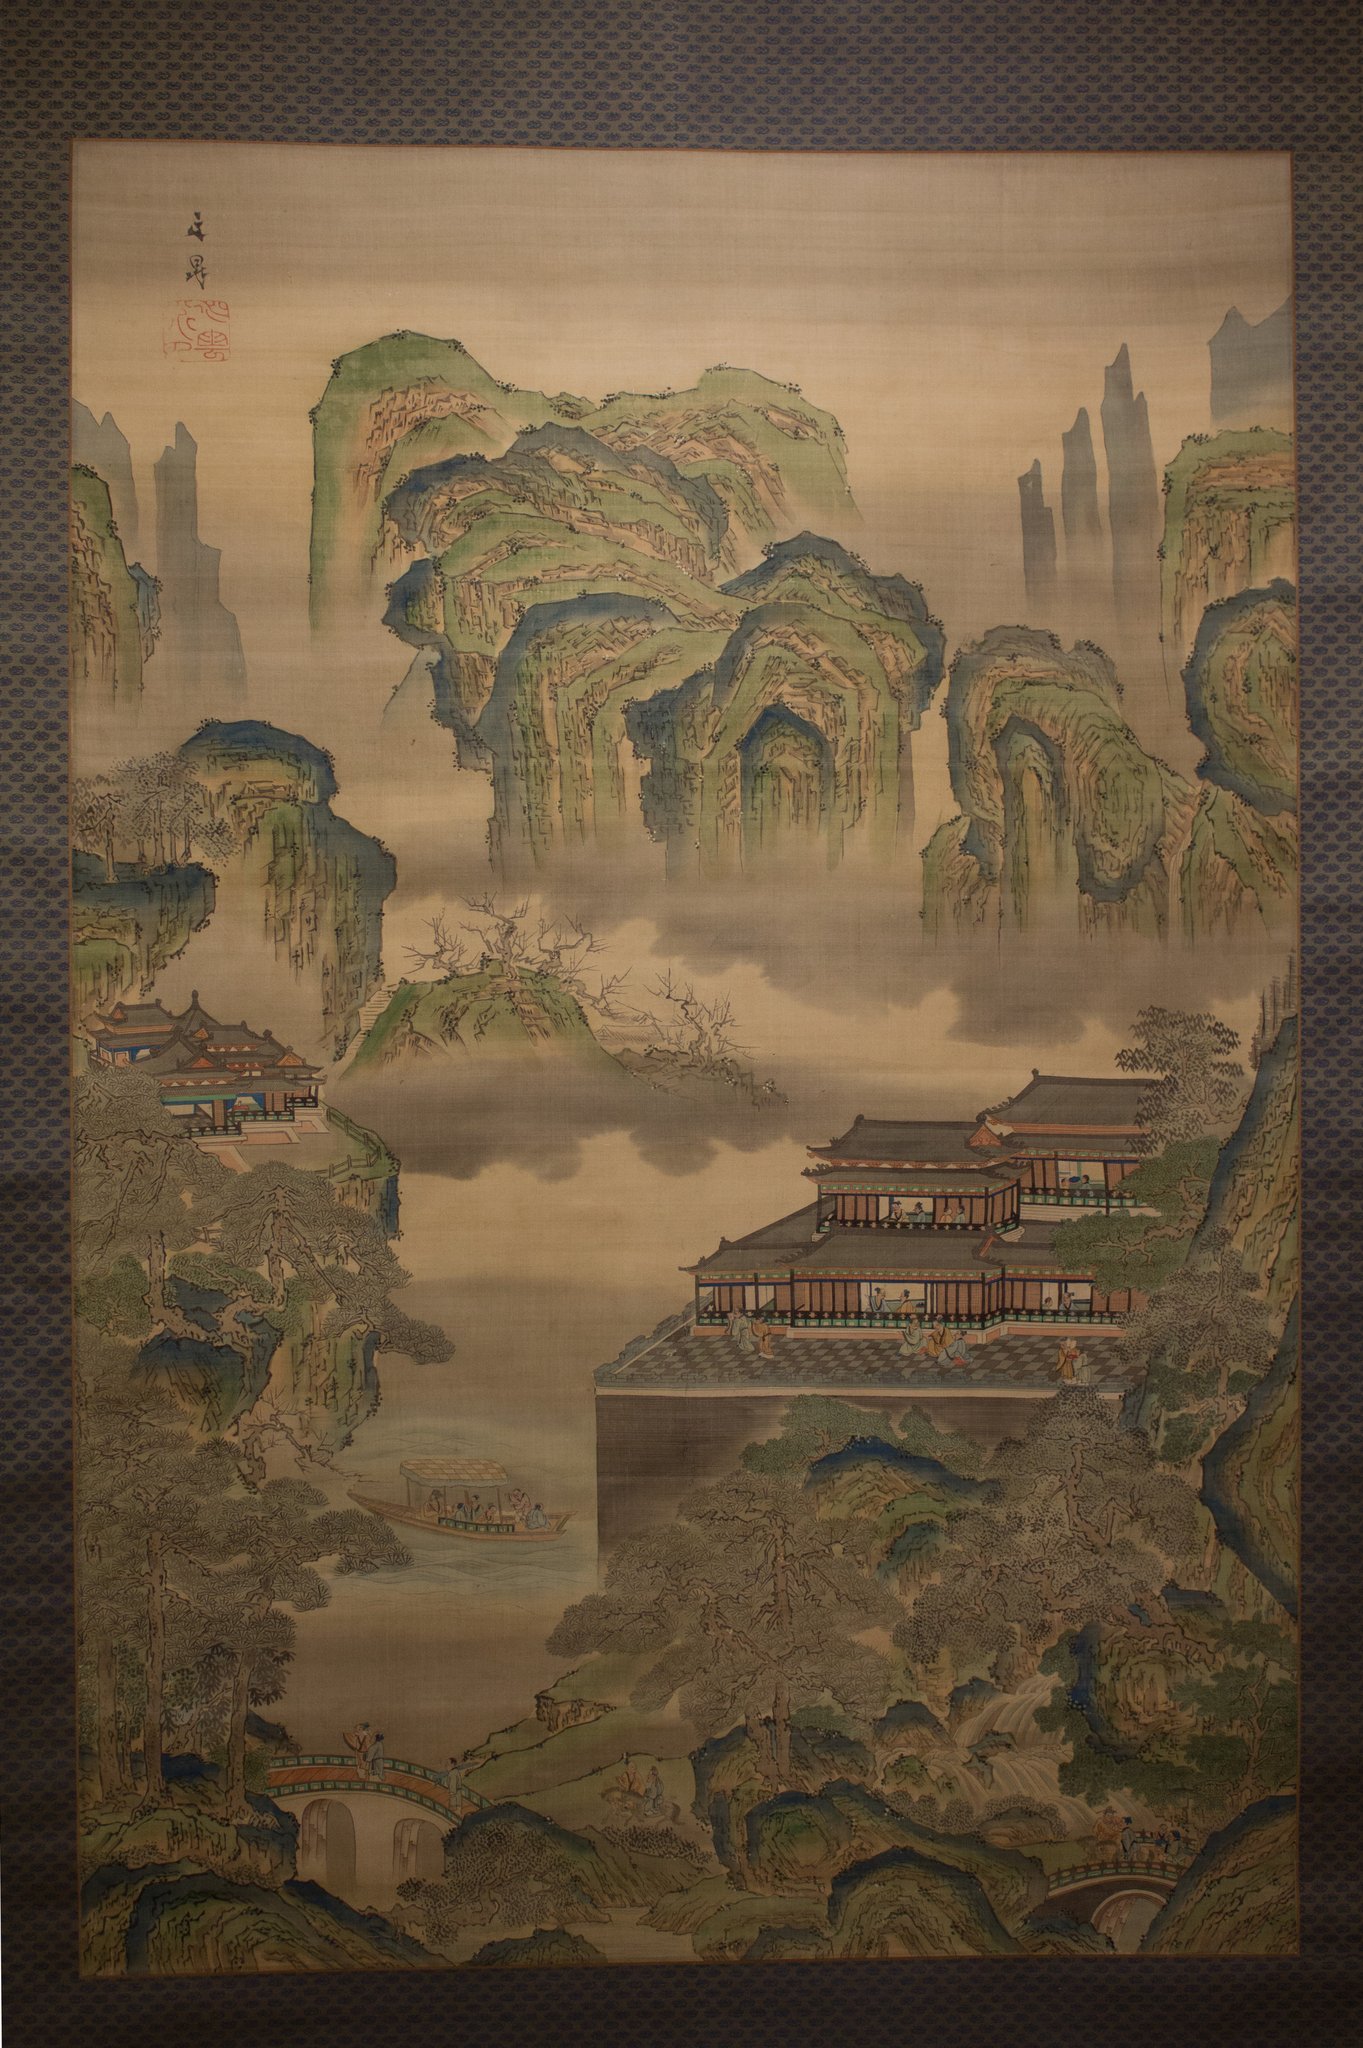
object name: hanging scroll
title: Palace Landscape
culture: japanese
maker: tani bunchō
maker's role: artist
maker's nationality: japanese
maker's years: 1763-1840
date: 1801-1833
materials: ink, silk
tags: palaces,landscapes,boats